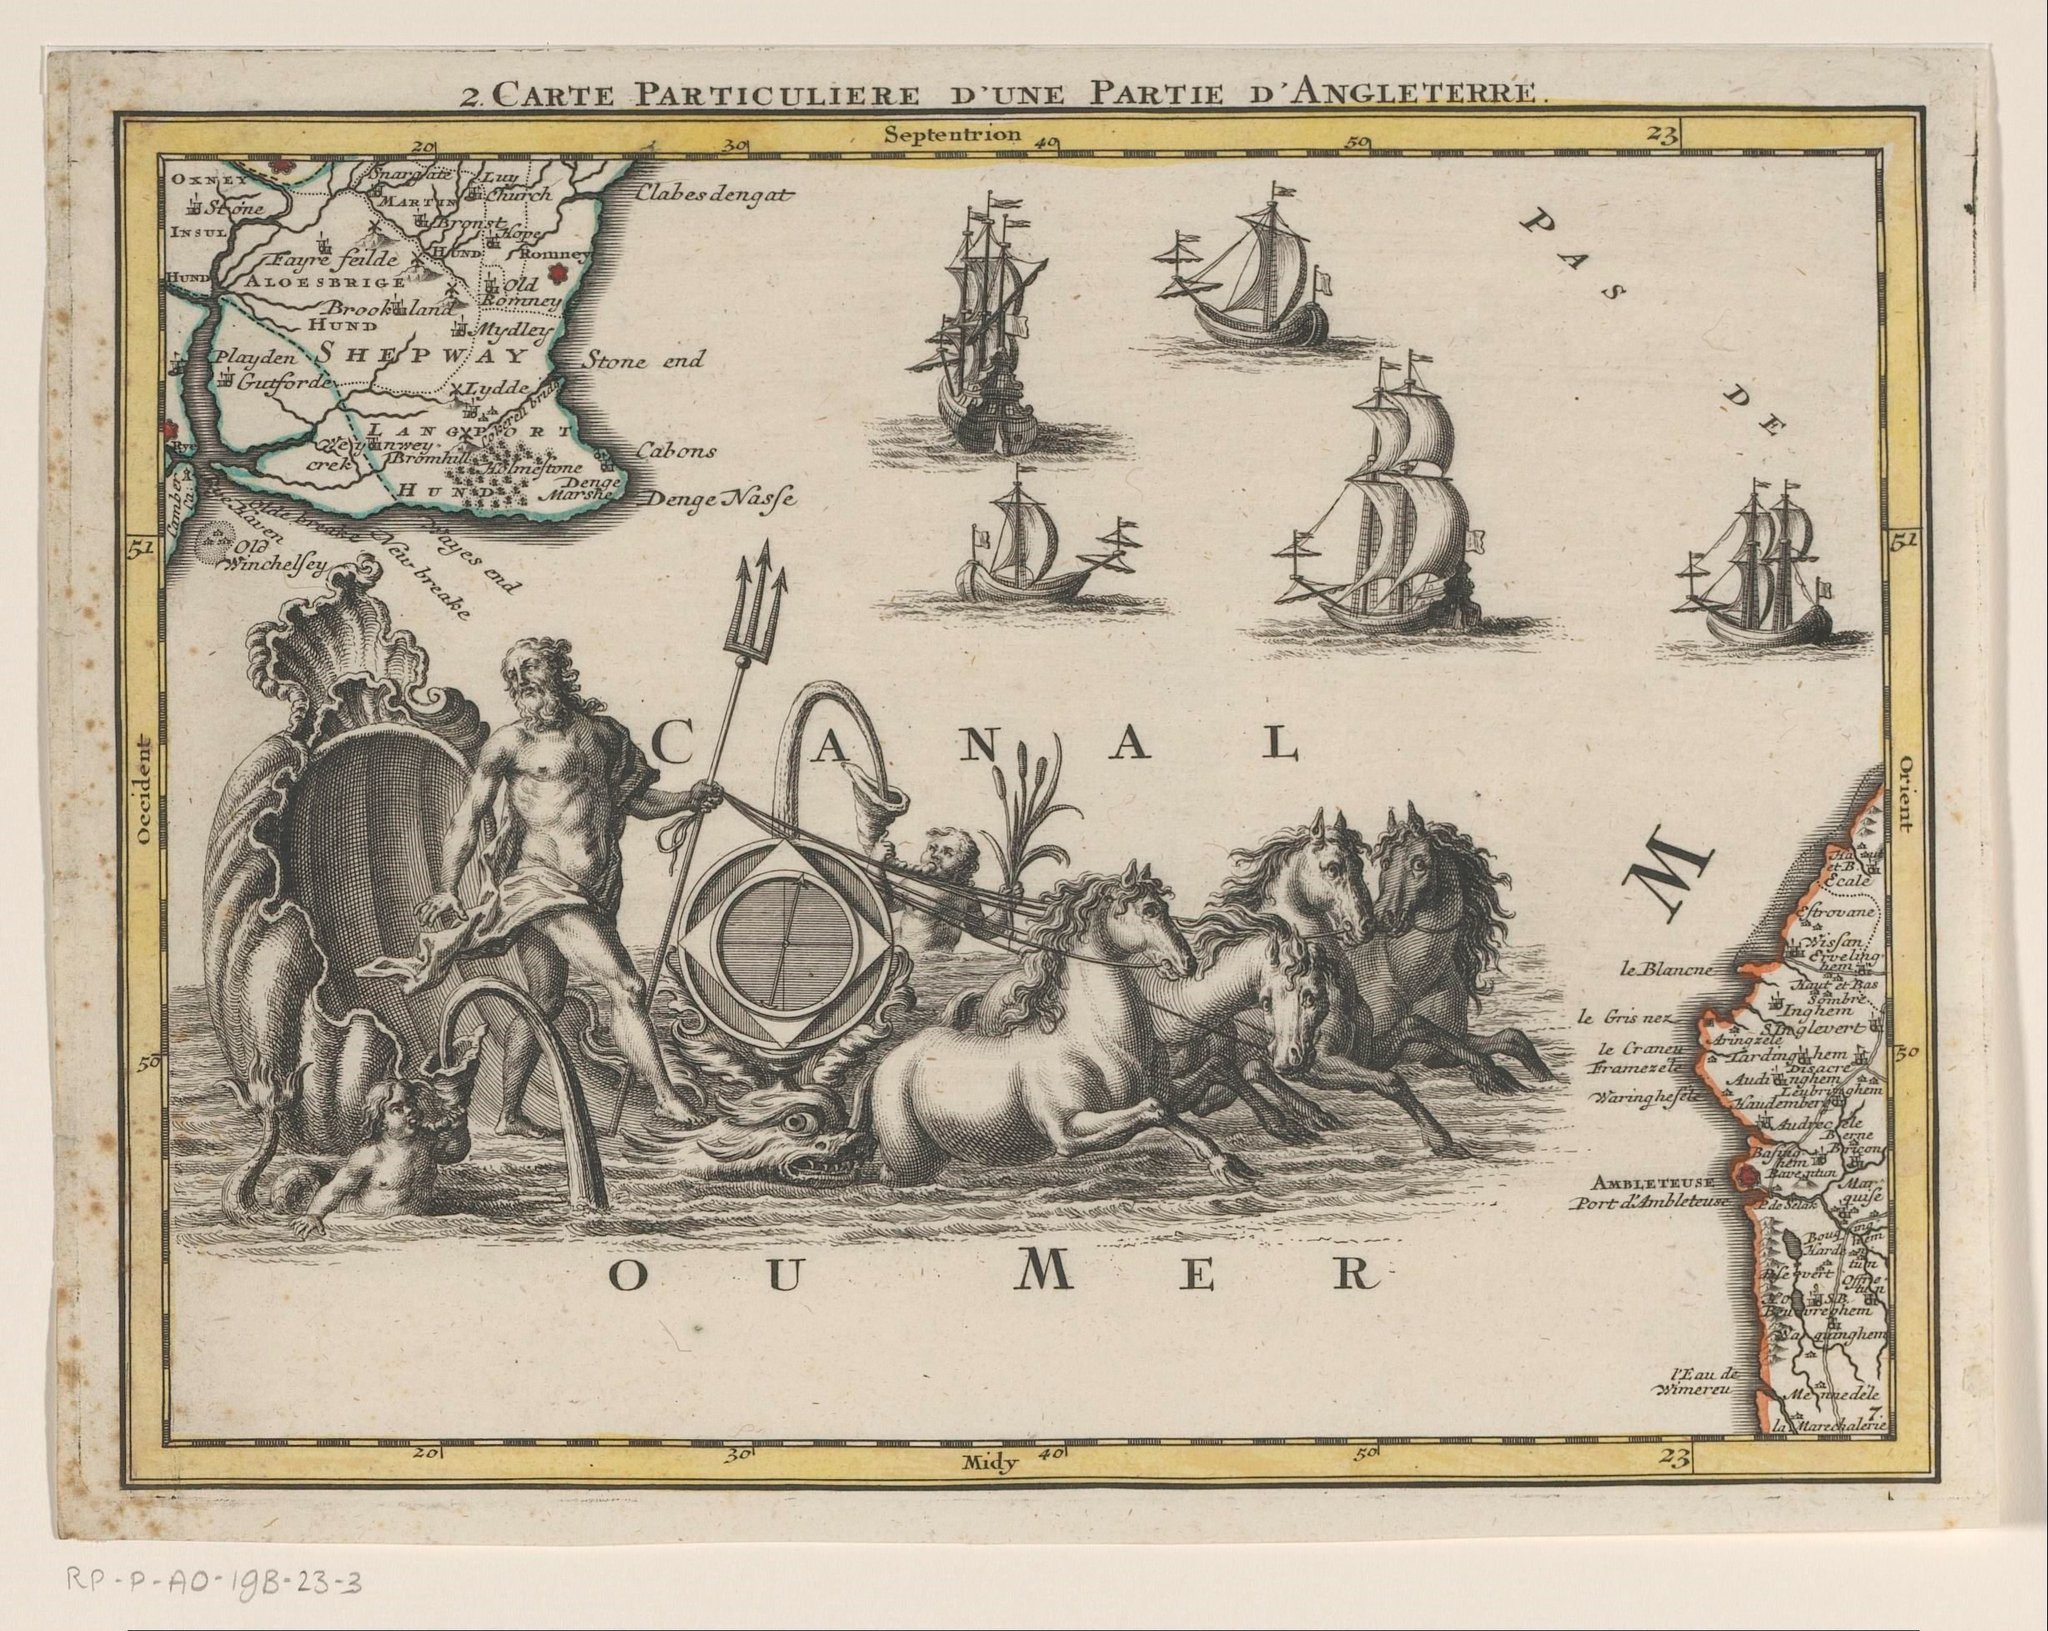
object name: print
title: Deel van een kaart van de Oostenrijkse Nederlanden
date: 1737-1757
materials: paper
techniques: engraving, etching, hand coloring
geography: augsburg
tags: maps of separate countries or regions, neptune as lord of the sea, southern netherlands, belgium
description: Deze kaart is onderdeel van een wandkaart van de Oostenrijkse Nederlanden, bestaande uit vier rijen van zes delen. De delen van de kaart zijn rechtsonder genummerd, beginnend bij het deel linksboven (1) tot het deel rechtsonder (24).